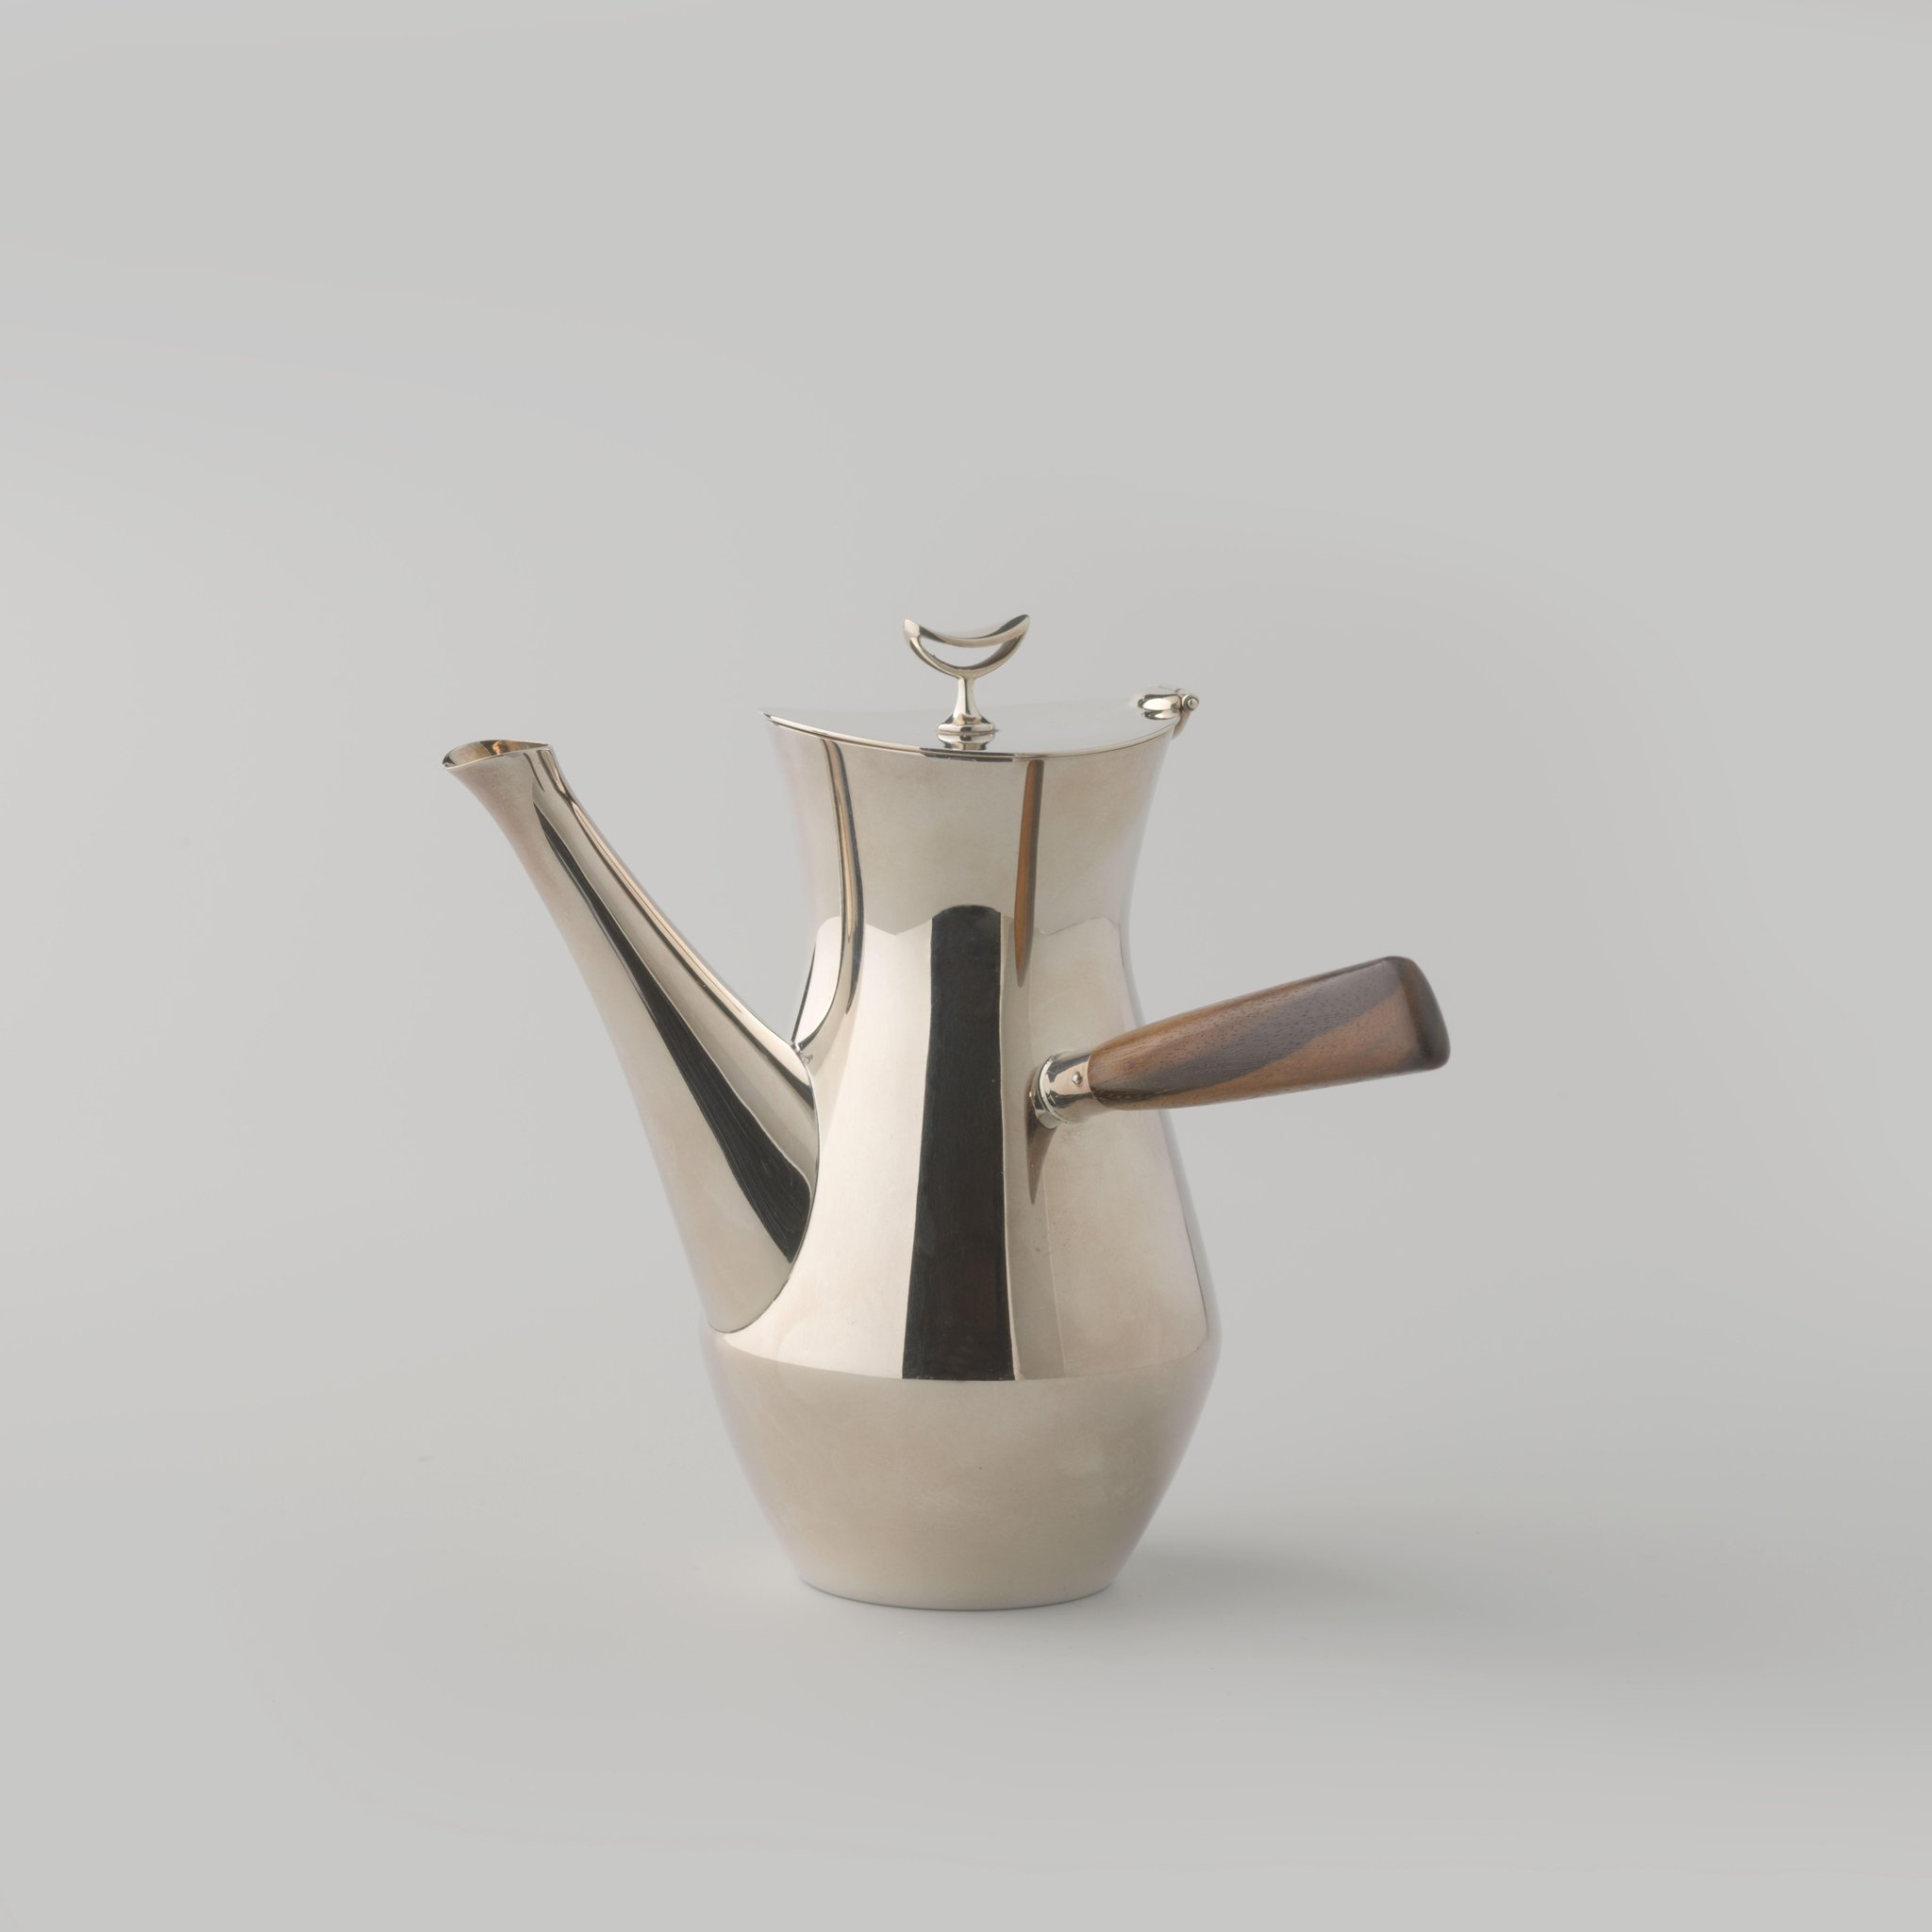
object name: mokkakan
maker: gustav beran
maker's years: 1912-2006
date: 1968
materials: wood, silver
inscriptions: mark: ‘Staande leeuw met 1 = 0.925 zilver, Minervakop met C = keurkamer Den Haag’, maker's mark: ‘VKB = N.V. Koninklijke Van Kempen & Begeer, Zeist-Voorschoten, jaarletter i = 1968’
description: Mokkakan behorende bij een vierdelig mokkaservies. De mokkakan is opgebouwd uit een vlakke bodem, een schuin naar buiten staand rond gedeelte en een diabolovormig ovaal deel. De kan wordt afgesloten door een hol gebogen deksel, die door een opengewerkte halve maan op een voetstuk wordt bekroond. De diabolo-vorm wordt in gerekte vorm herhaald in de schenktuit en de uitstaande greep van de mokka-kan.